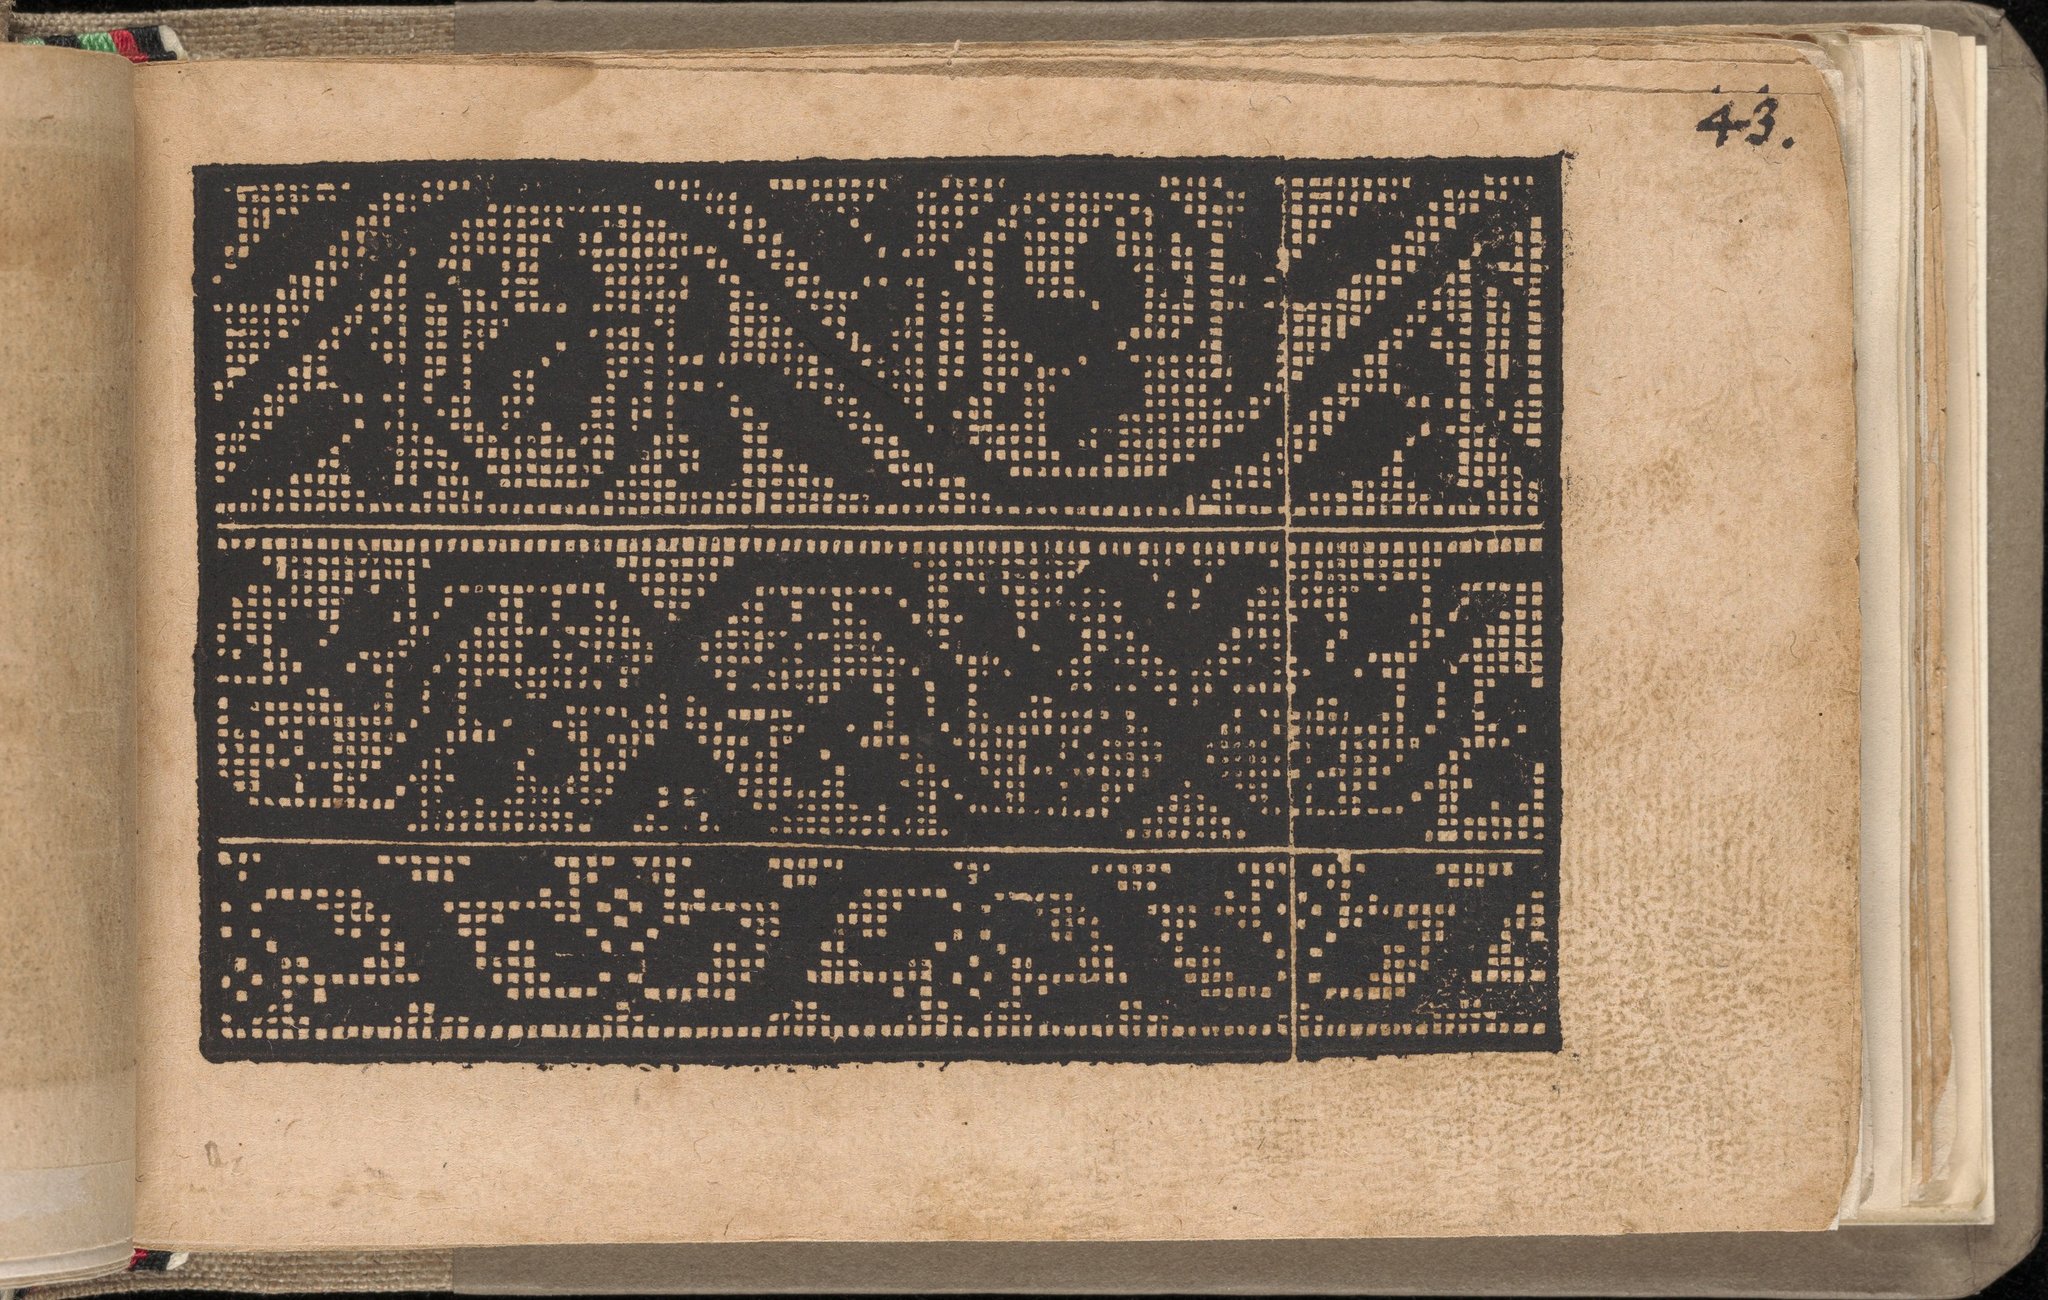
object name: book print ornament architecture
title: Schön newes Modelbuch (Page 43r)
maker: sigismundus latomus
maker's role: publisher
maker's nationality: german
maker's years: 1599-1632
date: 1608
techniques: woodcut